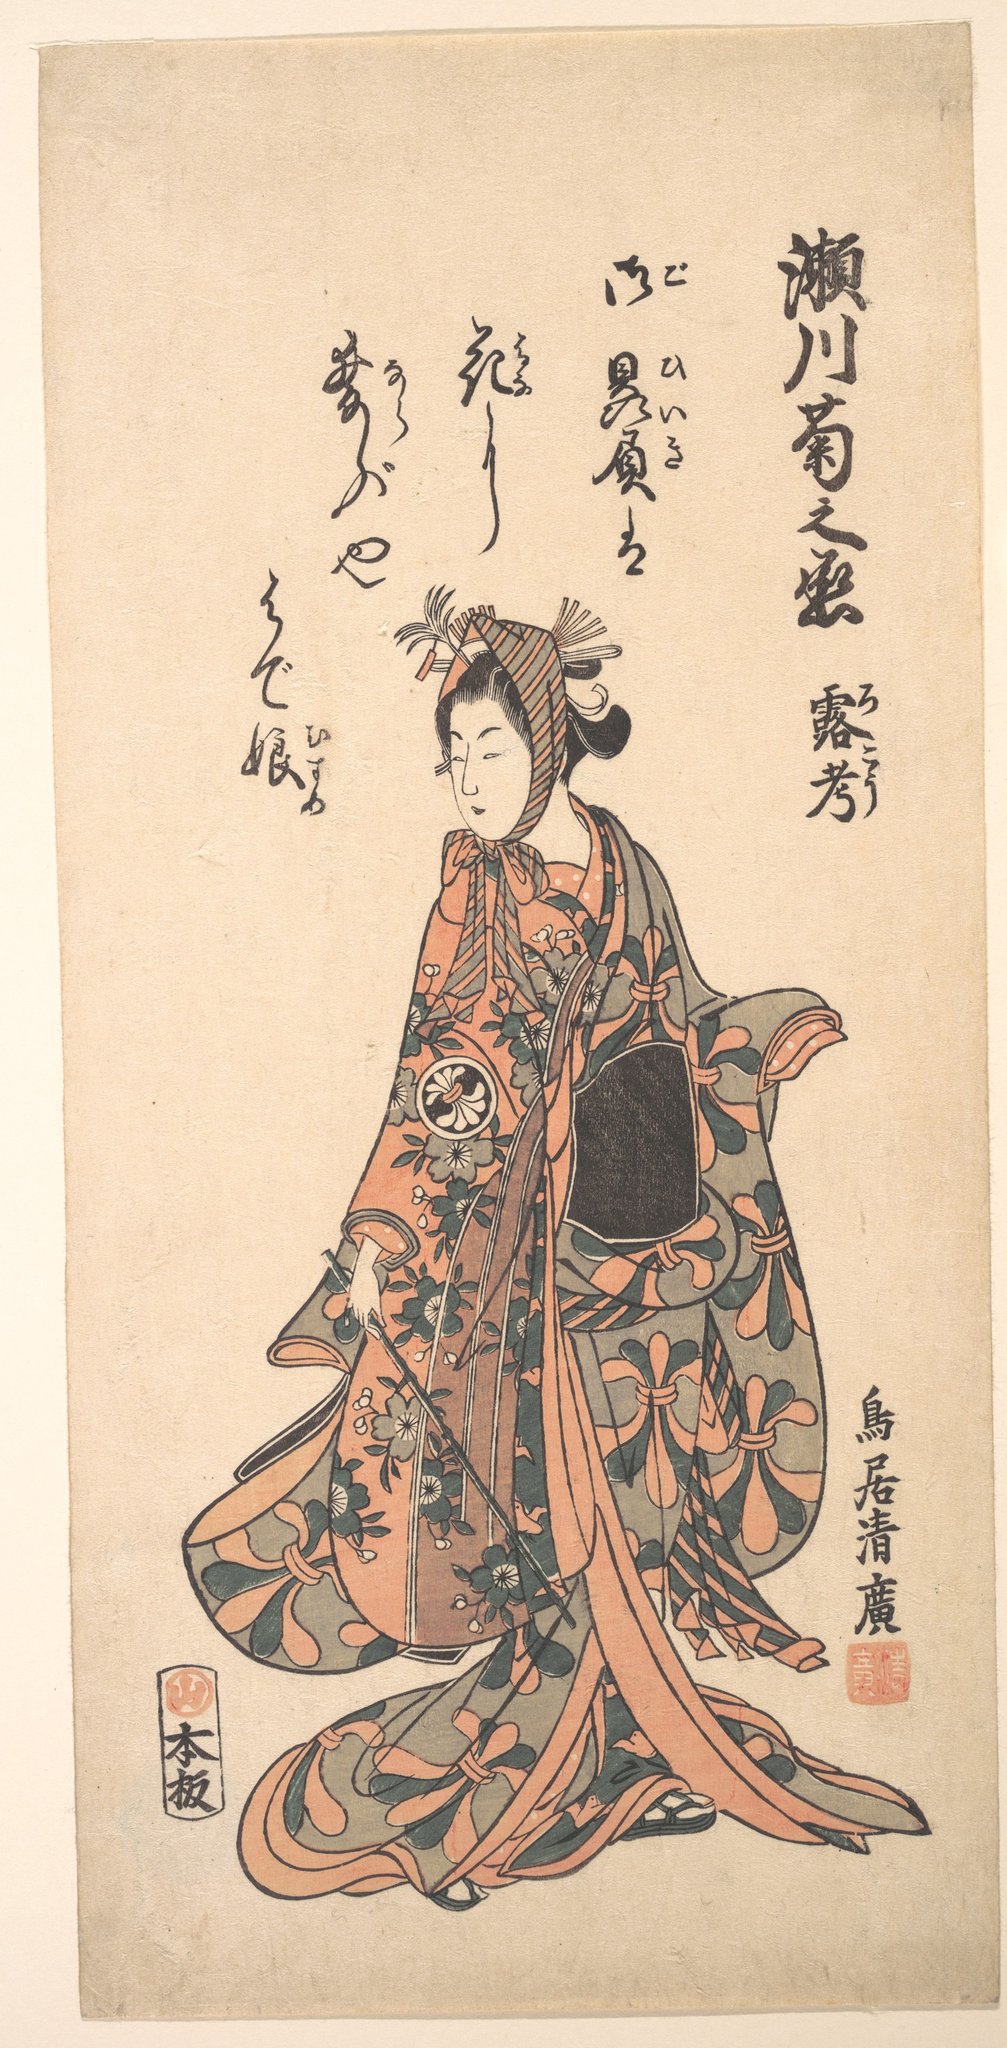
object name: print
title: Segawa Kikunojō II as a Woman Standing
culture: japanese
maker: torii kiyohiro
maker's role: artist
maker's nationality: japanese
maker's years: 1737-1776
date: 1757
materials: ink, paper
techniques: woodblock print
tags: women,actors